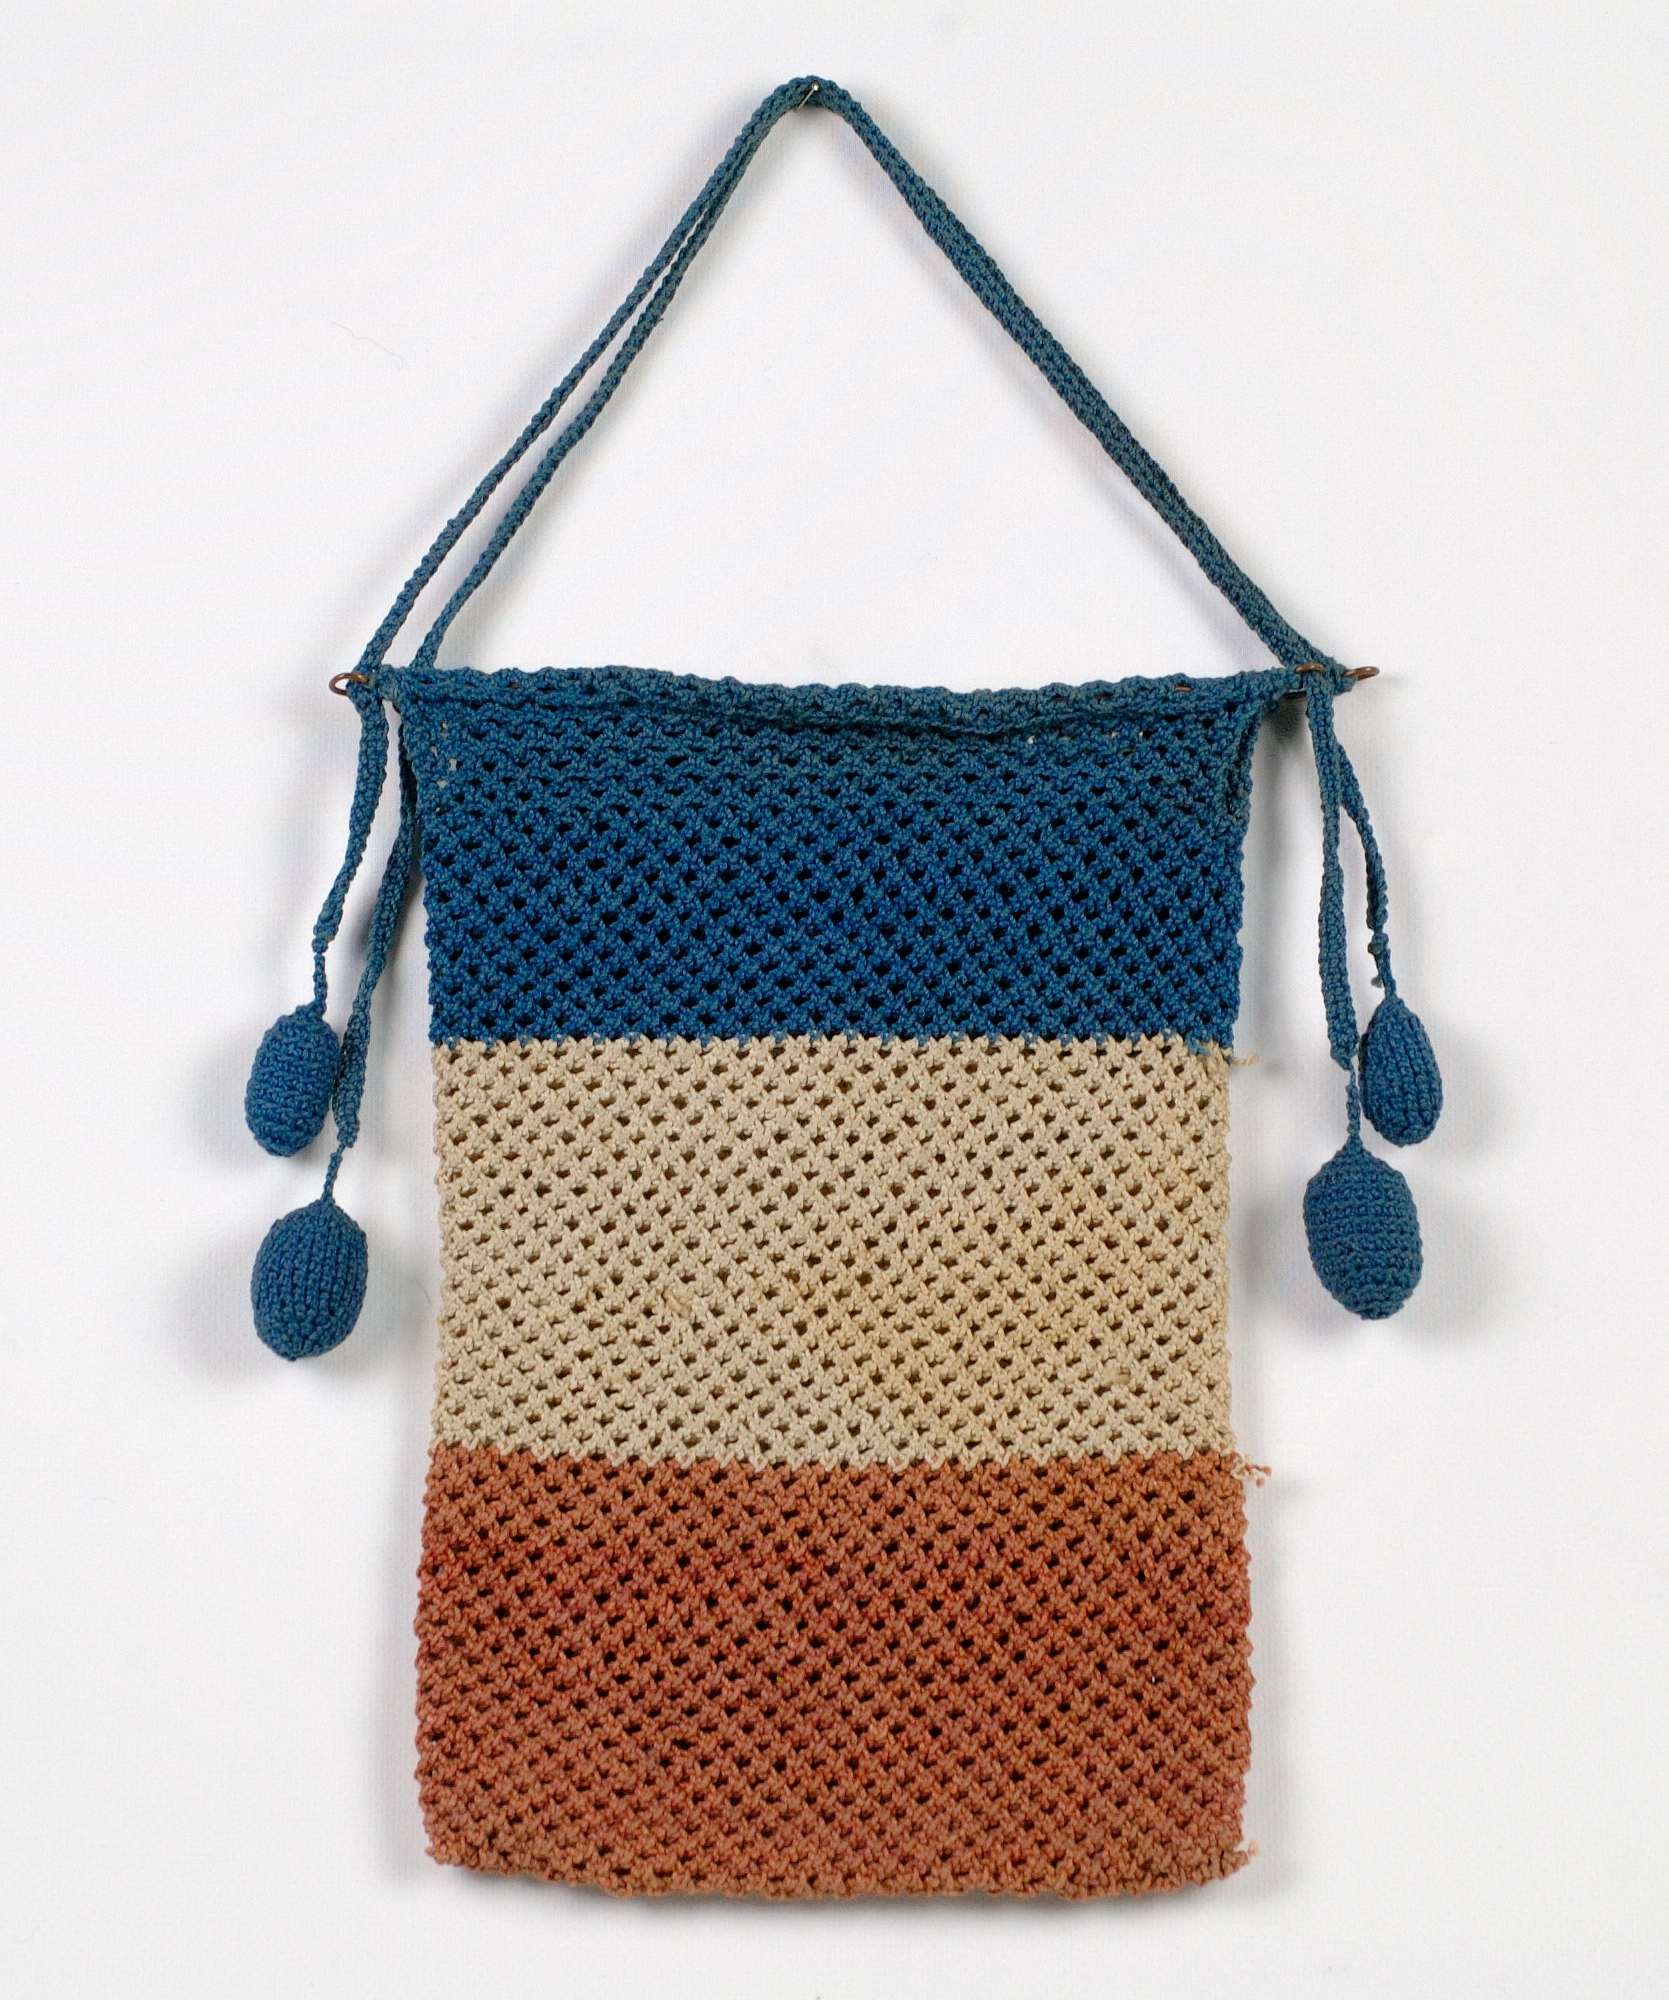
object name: bag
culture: american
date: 1876-1900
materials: cotton